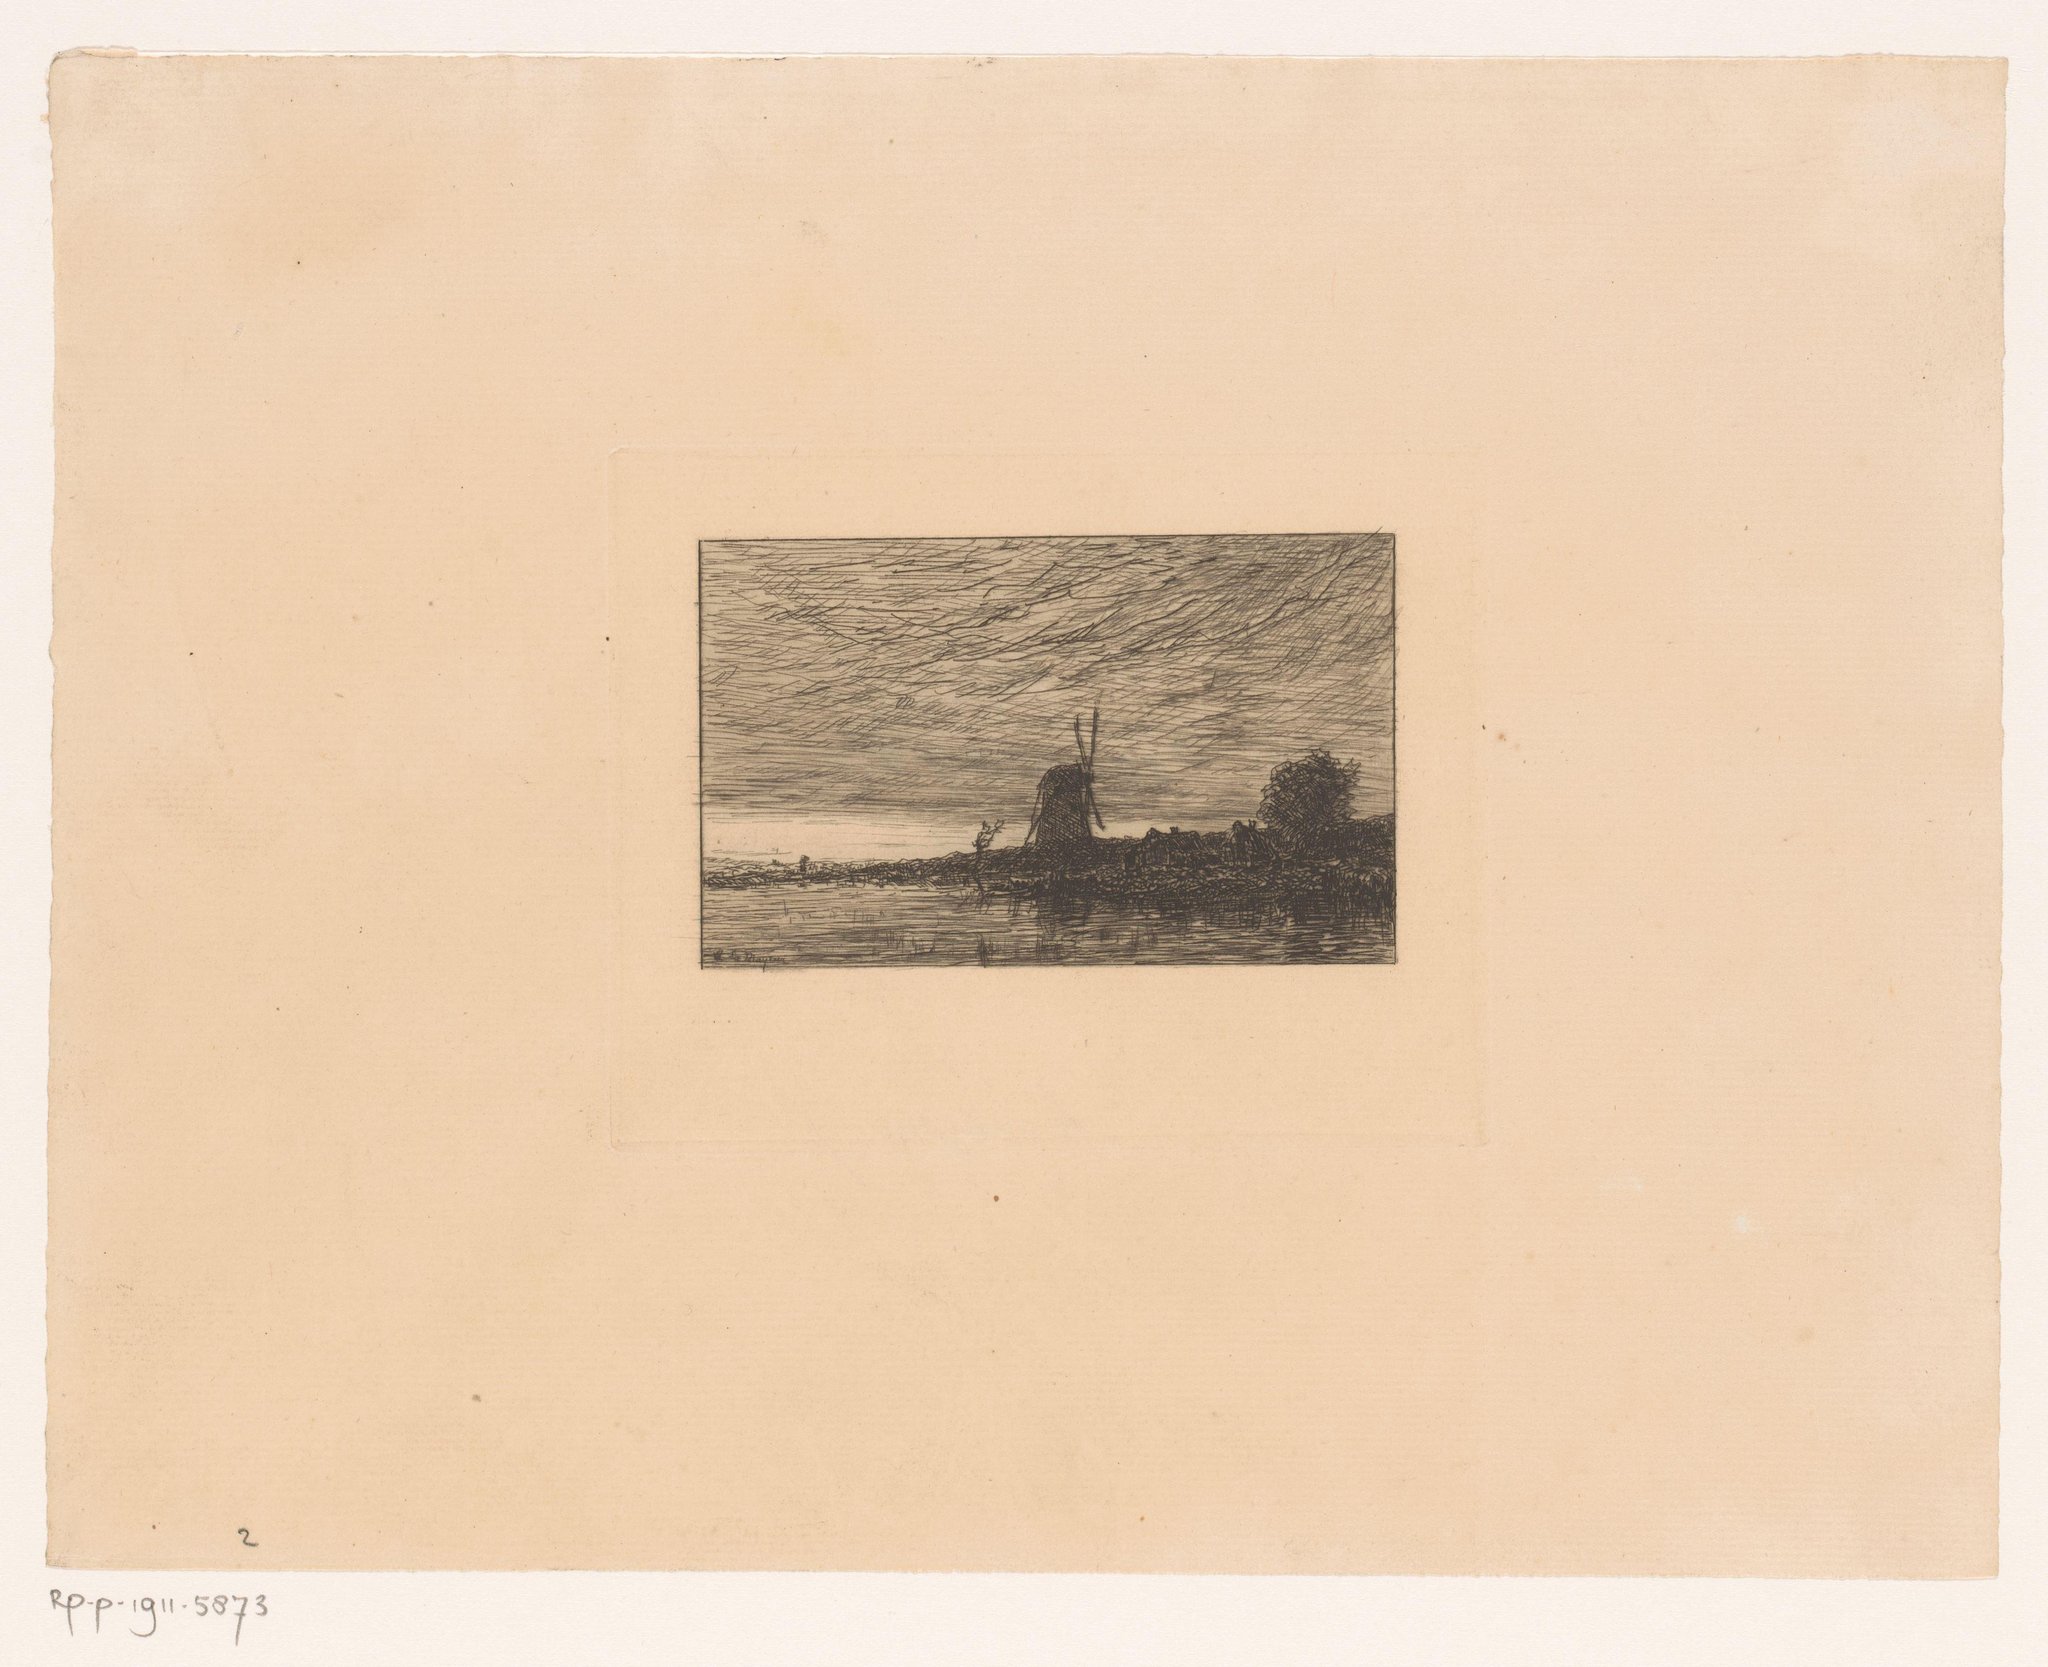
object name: print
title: Landschap met een molen aan water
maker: adrien le mayeur de merprés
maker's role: print maker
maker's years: 1844-1923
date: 1854-1911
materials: paper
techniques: etching, intaglio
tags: windmill in landscape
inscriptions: collector's mark: Lugt 2228